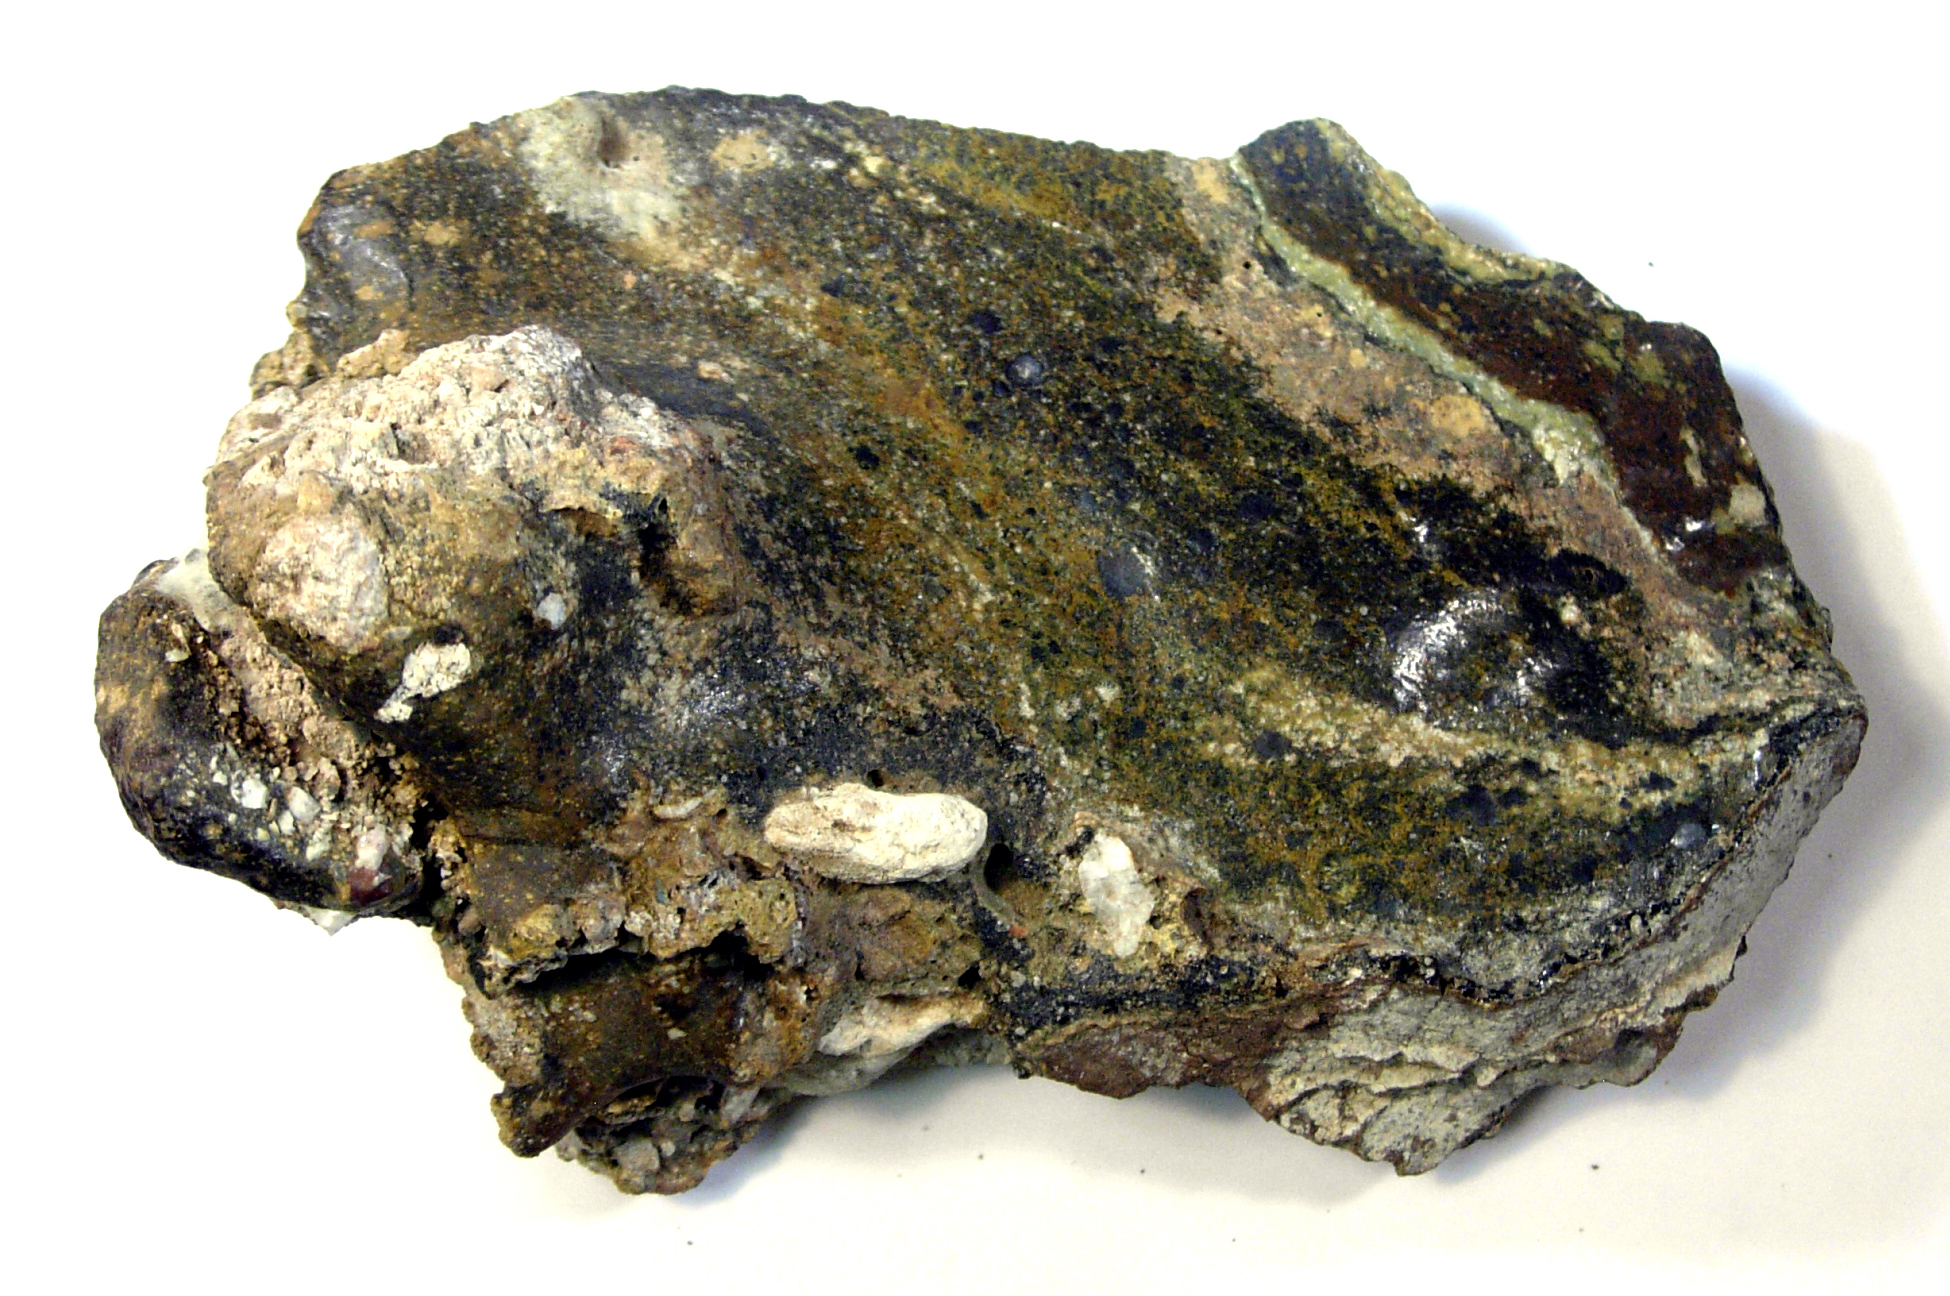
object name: fragment, glazing slag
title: Pieces of slag from glazing process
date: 1802-1450 BCE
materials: glaze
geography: egypt